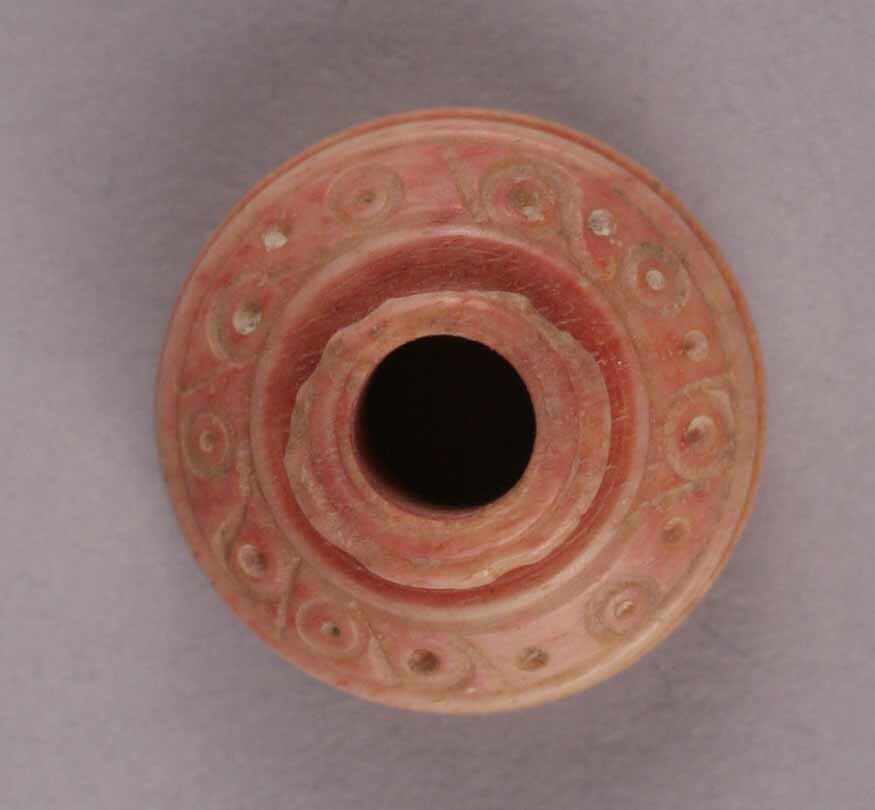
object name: spindle whorl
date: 801-1000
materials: bone, paint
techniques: incising, inlay, tinting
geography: iran